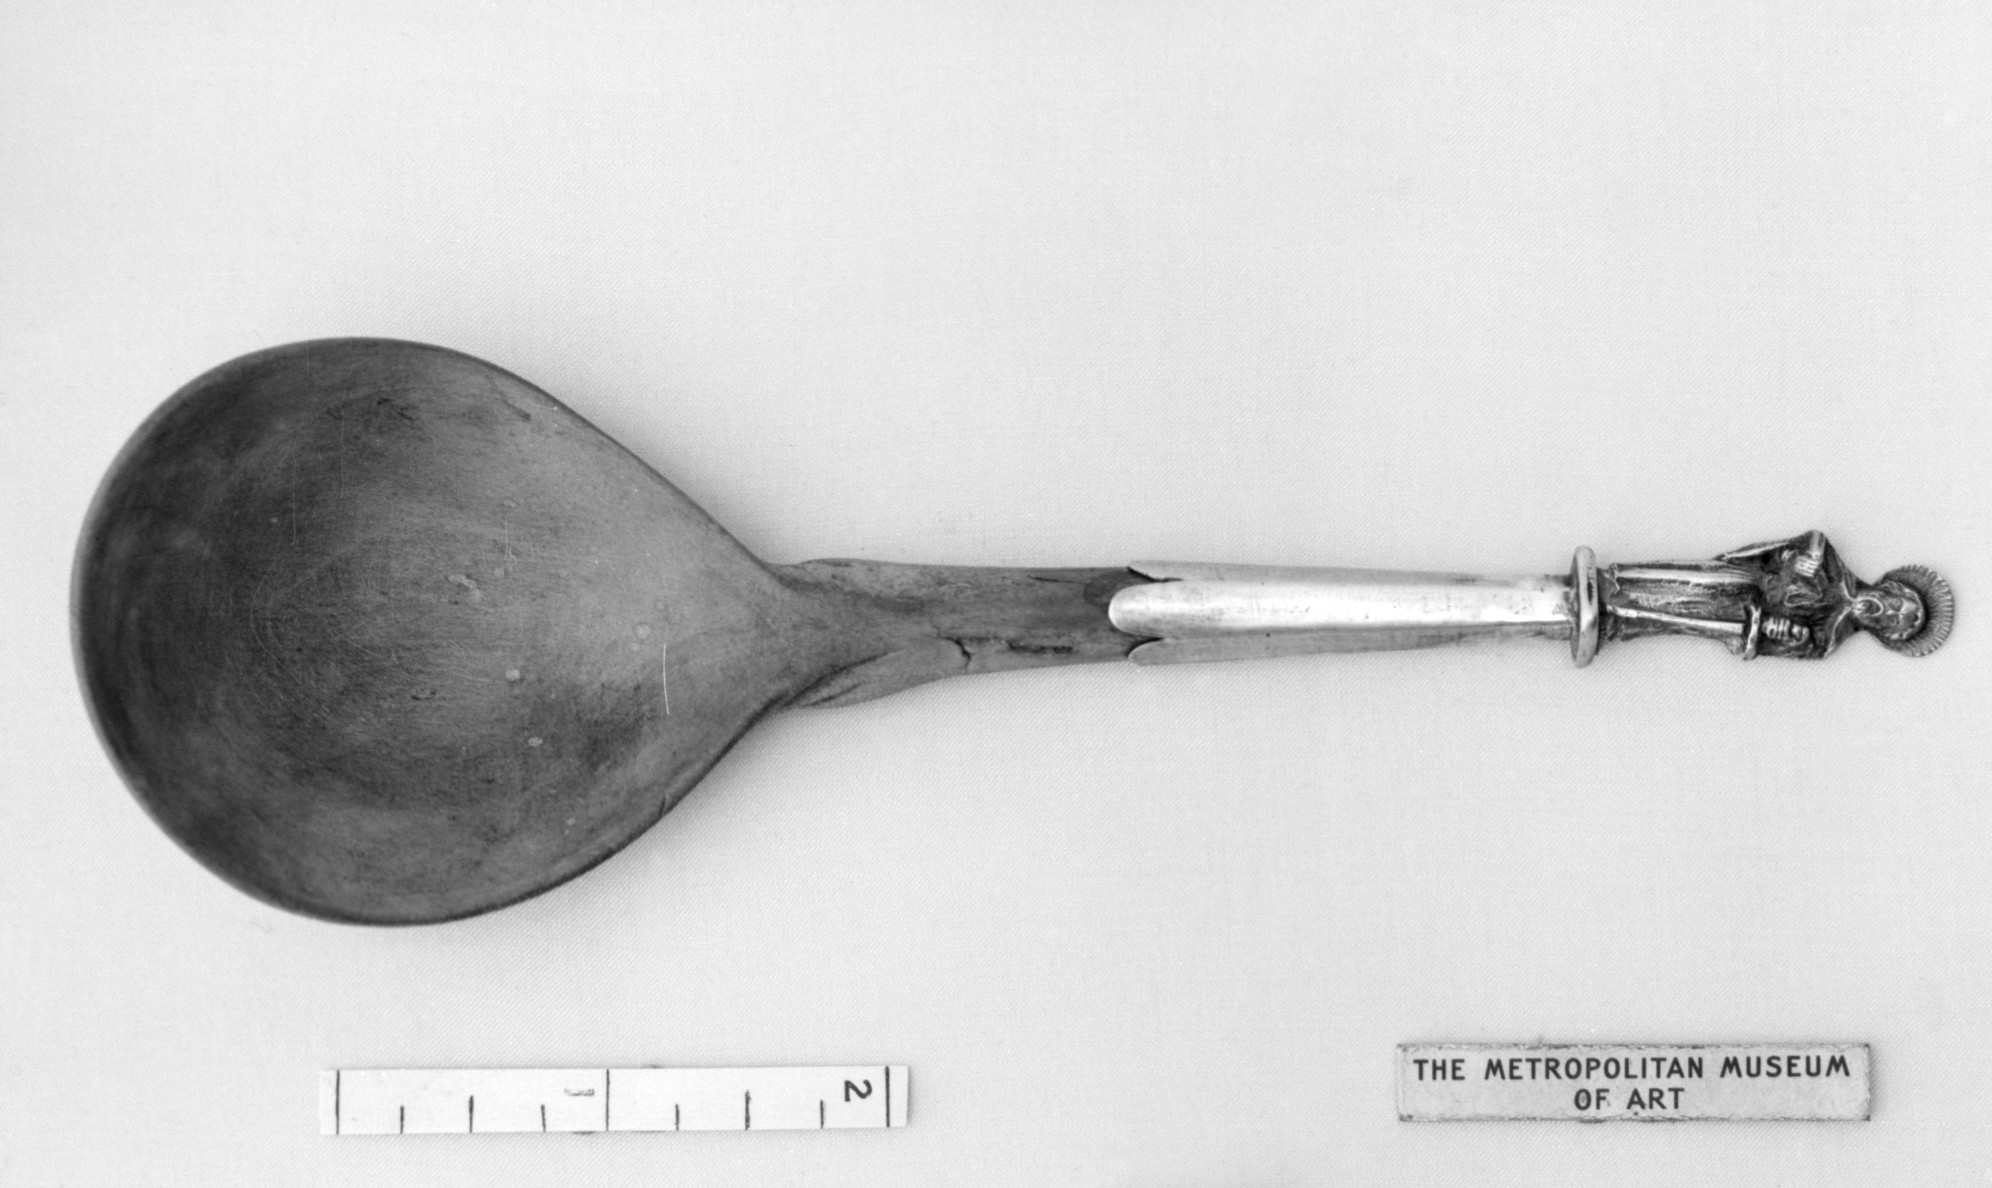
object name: apostle spoon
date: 1600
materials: silver, wood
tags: men